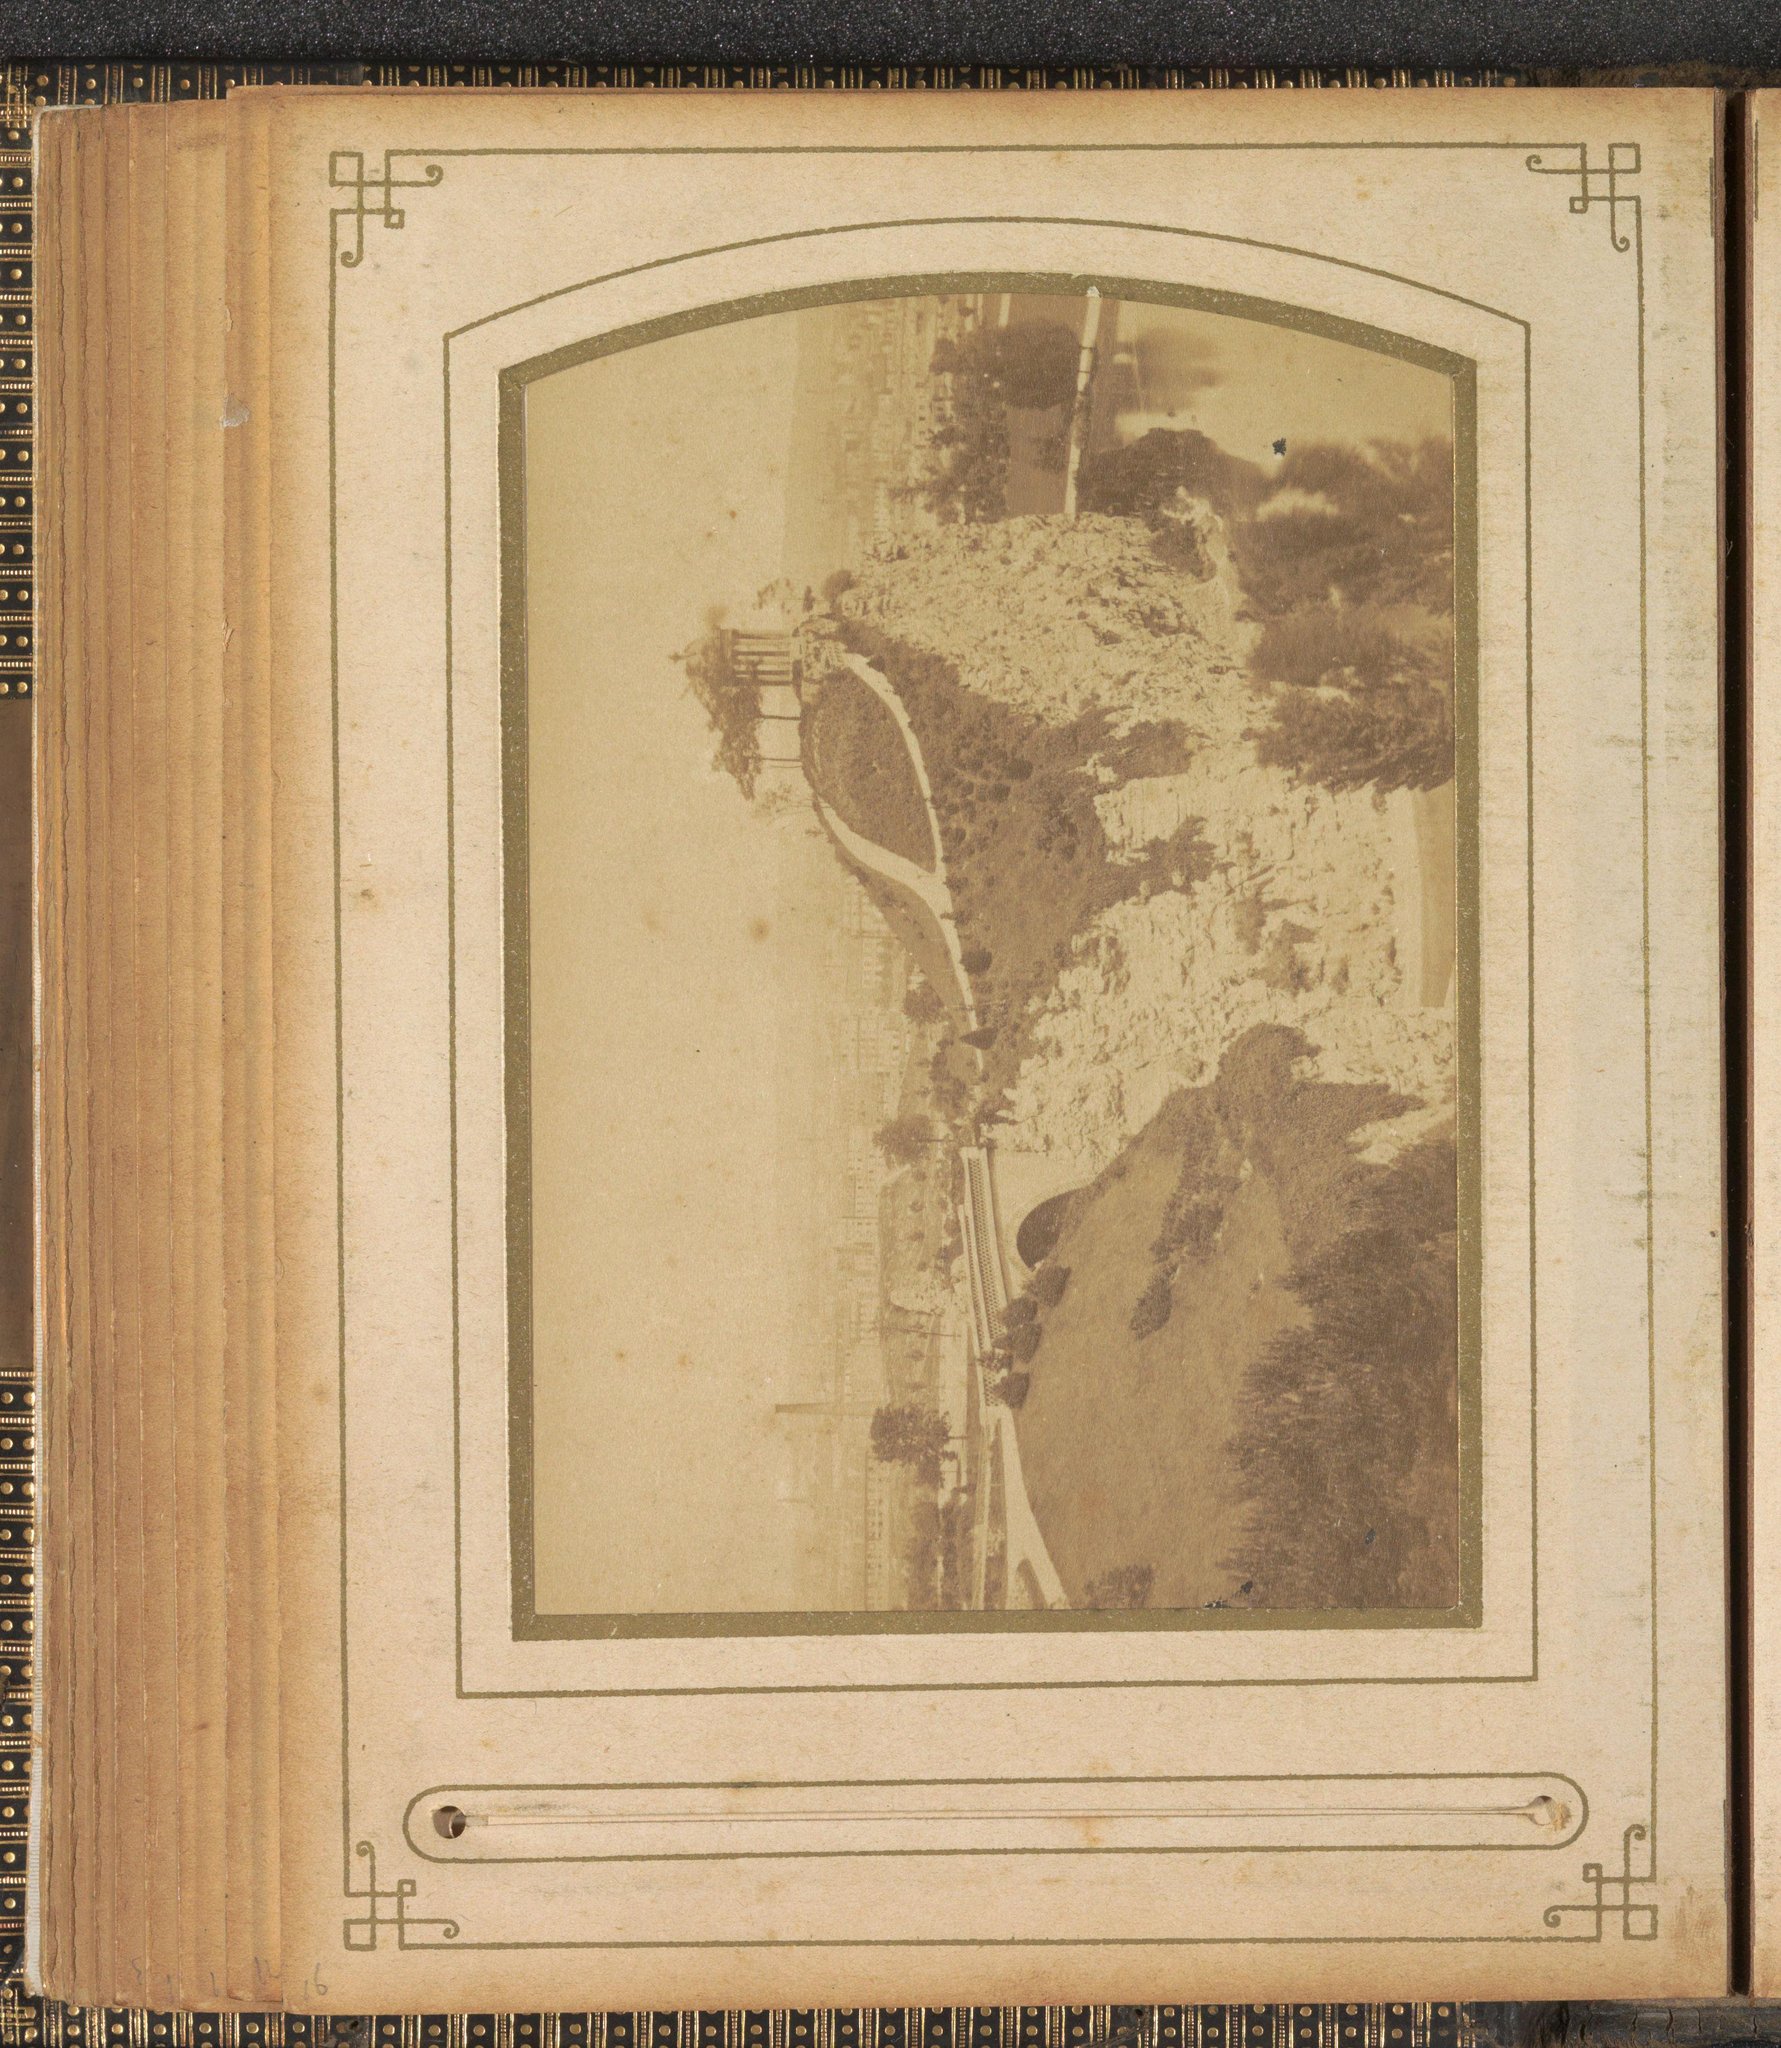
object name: cabinet photograph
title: Stadspark Les buttes de Chaumont met rechts de Tempel van de Sibylle in Parijs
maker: Anonymous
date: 1870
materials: cardboard, paper, photographic support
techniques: albumen print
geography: paris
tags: public gardens, park (+ city(-scape) with figures, staffage), temple, shrine ~ roman religion, temple, shrine ~ greek religion, paris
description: Onderdeel van Fotoalbum met kabinetfoto's van bezienswaardigheden in Parijs.